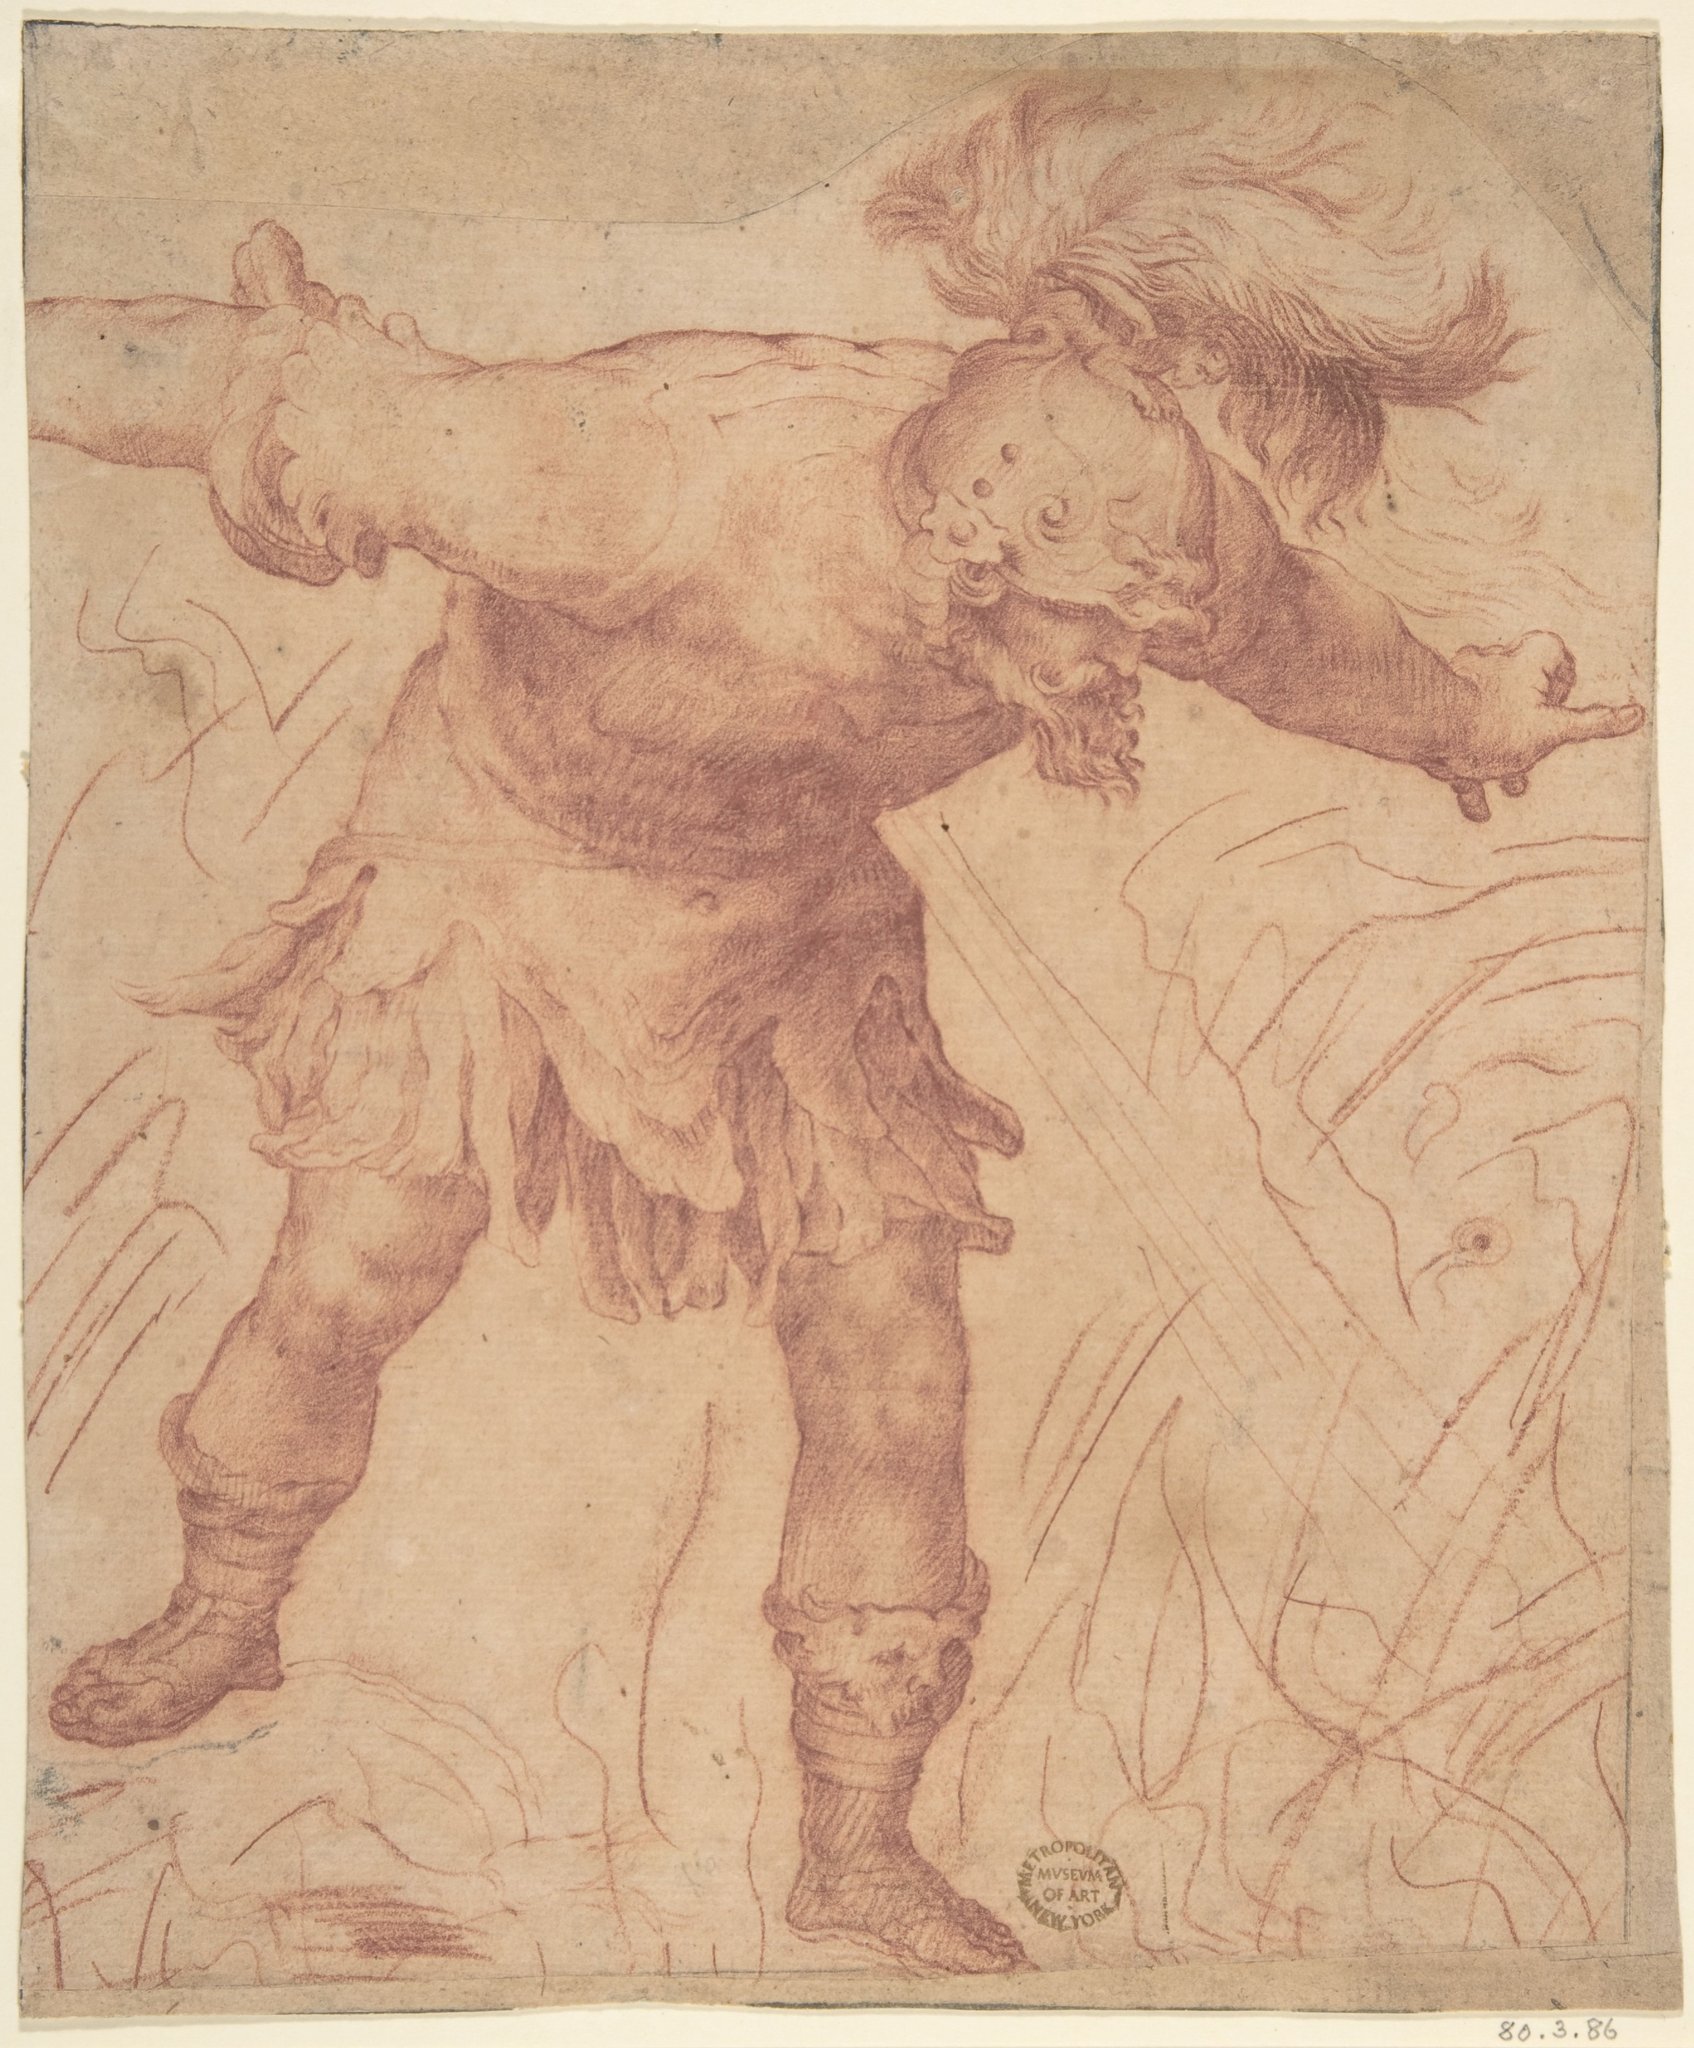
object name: drawing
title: King Saul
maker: anonymous, dutch, 17th century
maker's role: artist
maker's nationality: dutch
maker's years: 1600-1700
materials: chalk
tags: kings